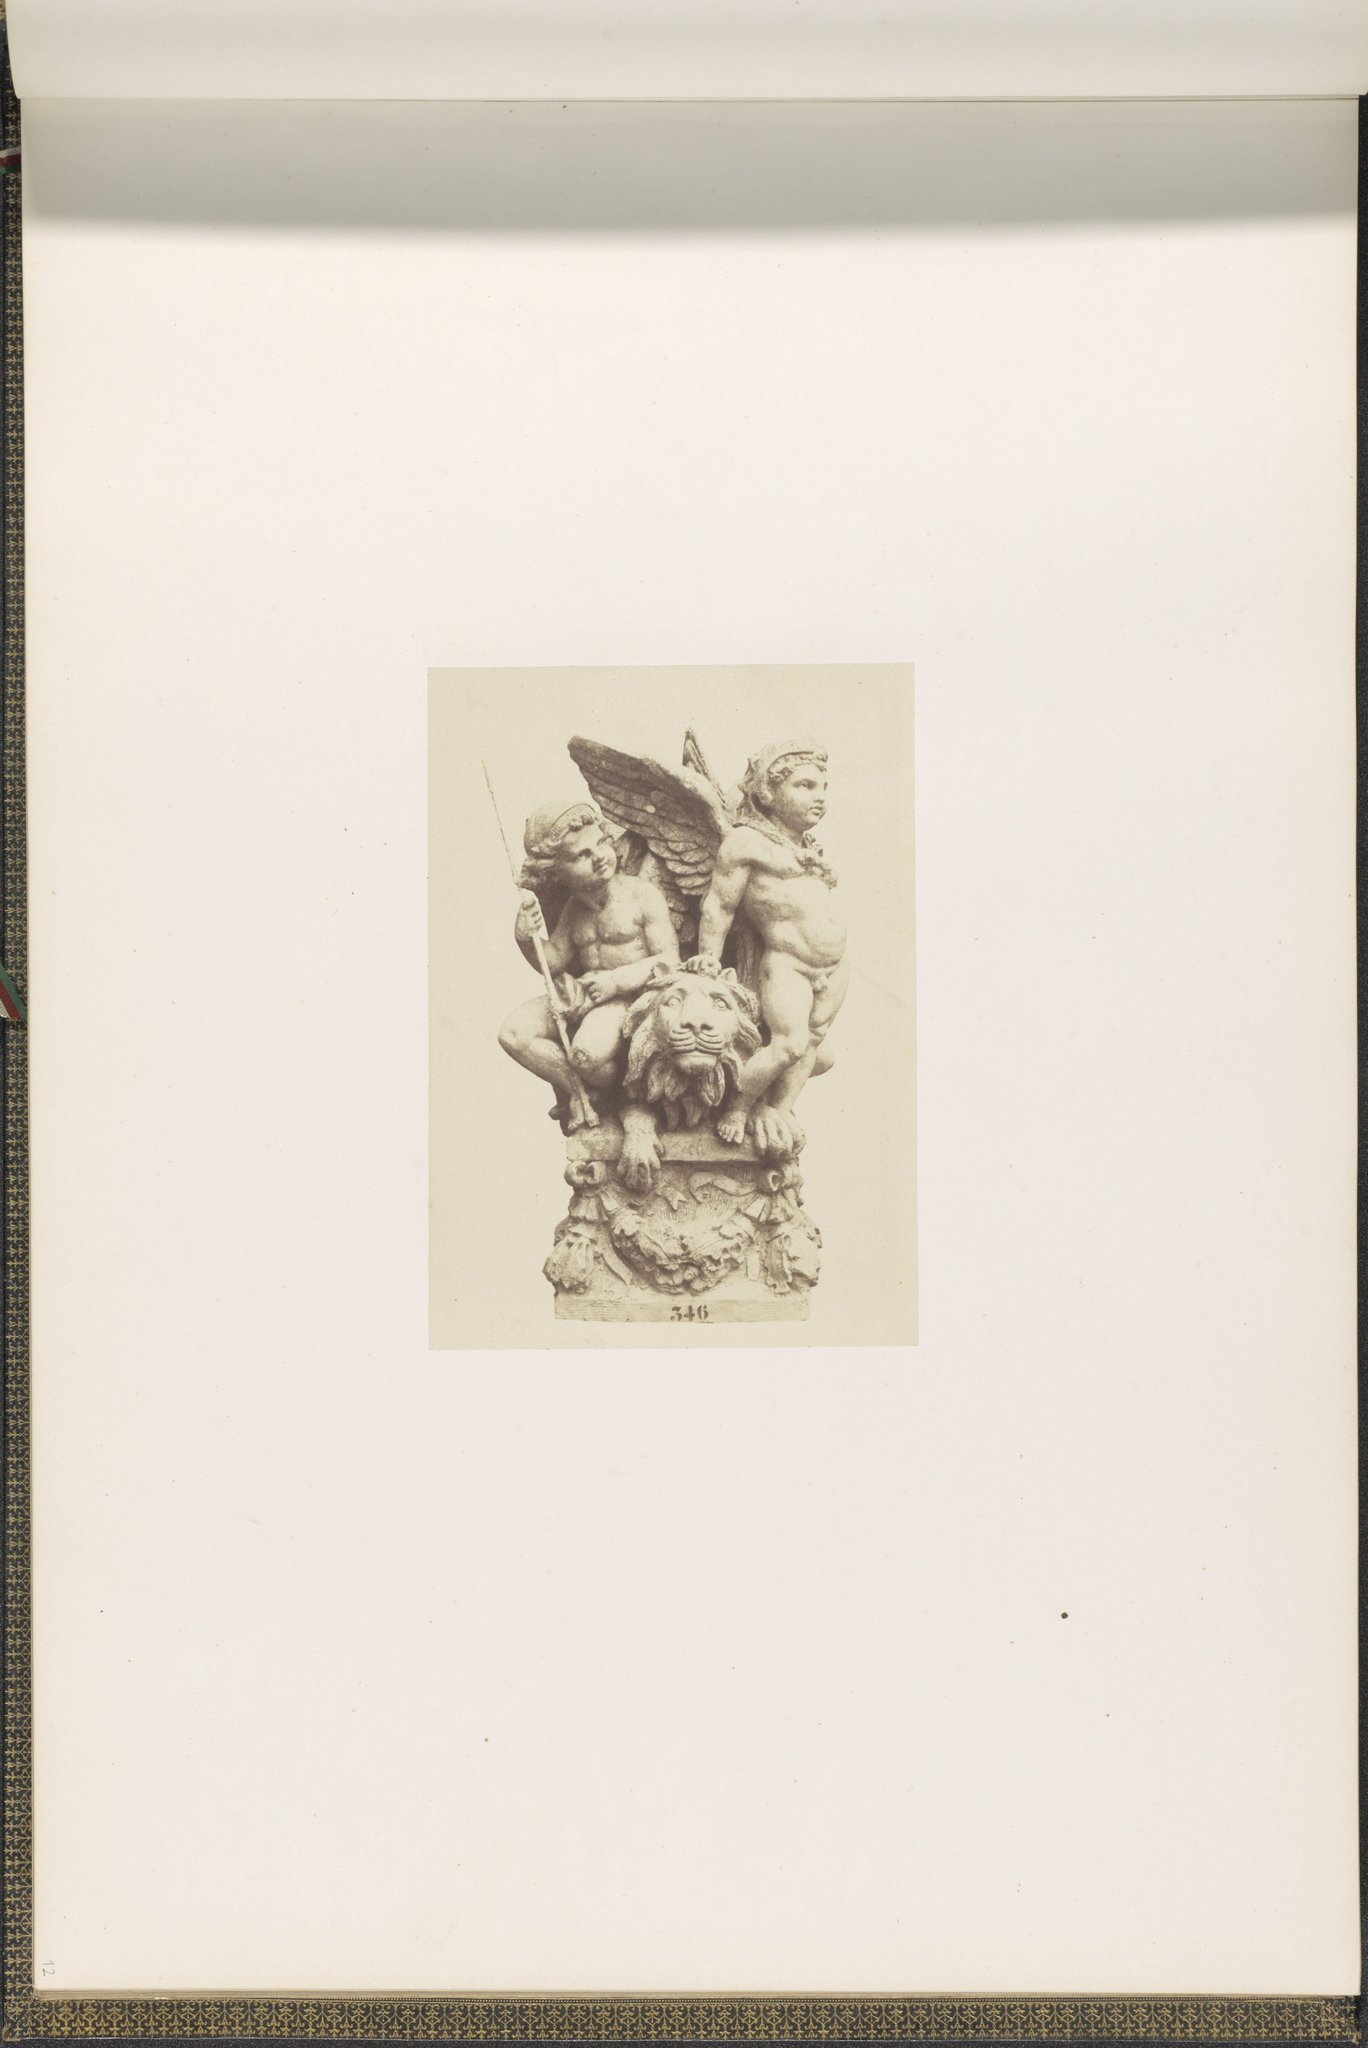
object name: photograph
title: Gipsmodel voor beeldhouwwerk op het Palais du Louvre: "La Force" door Louis Léopold Chambard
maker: édouard denis baldus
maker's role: fotograaf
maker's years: 1813-1889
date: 1855-1857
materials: paper, photographic support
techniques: salted paper print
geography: paris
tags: piece of sculpture, reproduction of a piece of sculpture, permanent exhibition, museum, paris, tuileries palace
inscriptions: number: ‘346’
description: Onderdeel van Réunion des Tuileries au Louvre 1852-1857, album 4.